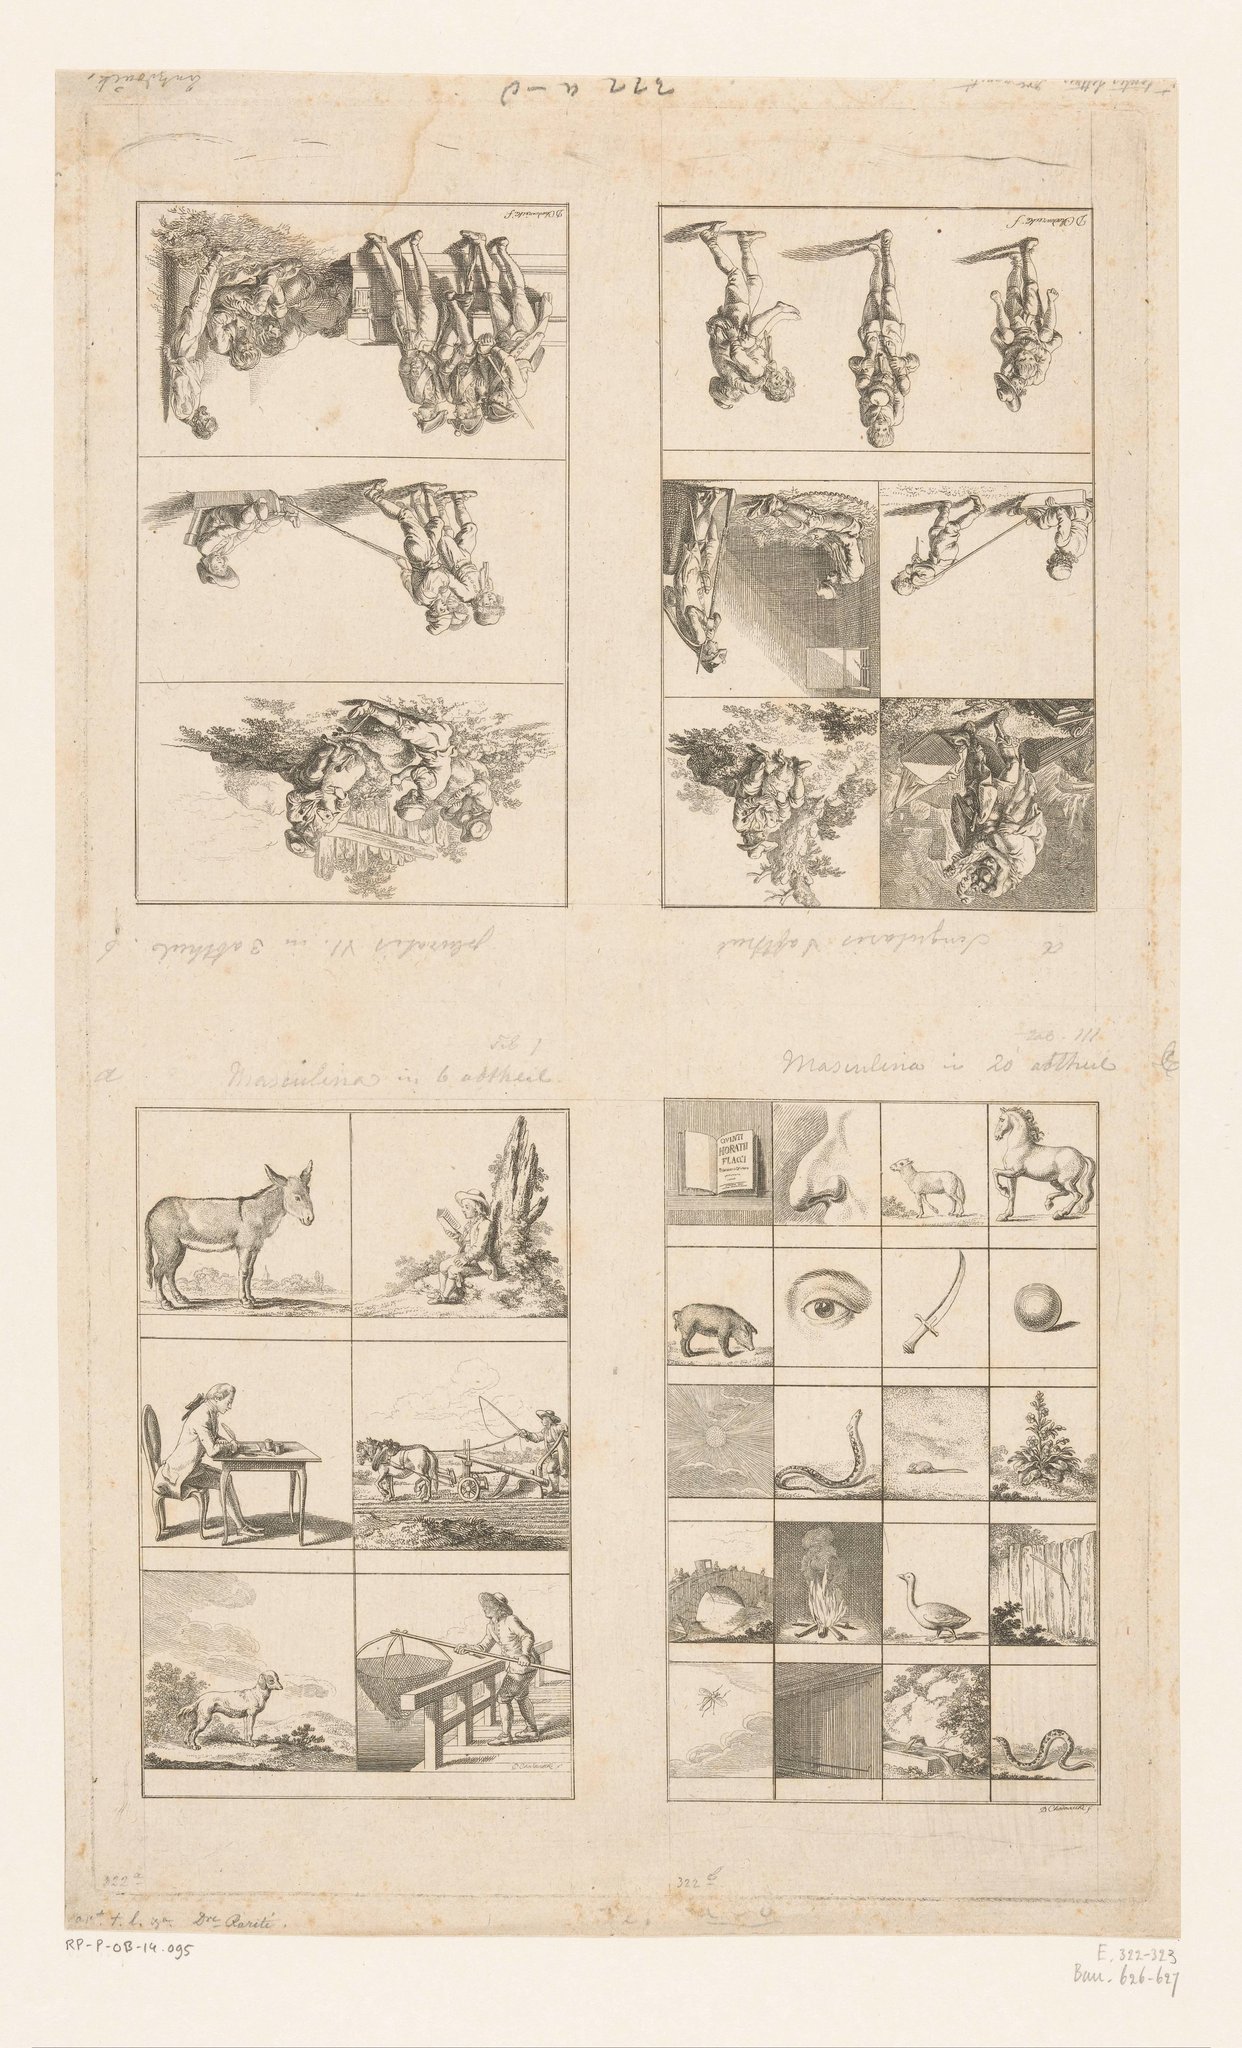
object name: print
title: Voorbeelden van zelfstandige naamwoorden in het Latijn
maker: daniel nikolaus chodowiecki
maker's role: draughtsman, print maker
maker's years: 1726-1801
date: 1779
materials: paper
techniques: etching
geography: berlin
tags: pedagoog, professor, friedrich schulz (1753-1817)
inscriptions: collector's mark: Lugt 2228, inscription: ‘Aetzdrück’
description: Deze prent maakt deel uit van een serie van acht prenten. Deze prenten zijn gebruikt in: Schulz, Johann Michael Friedrich. Elementarbuch der lateinischen Sprache. 2 dln. Berlijn: August Mylius, 1779.